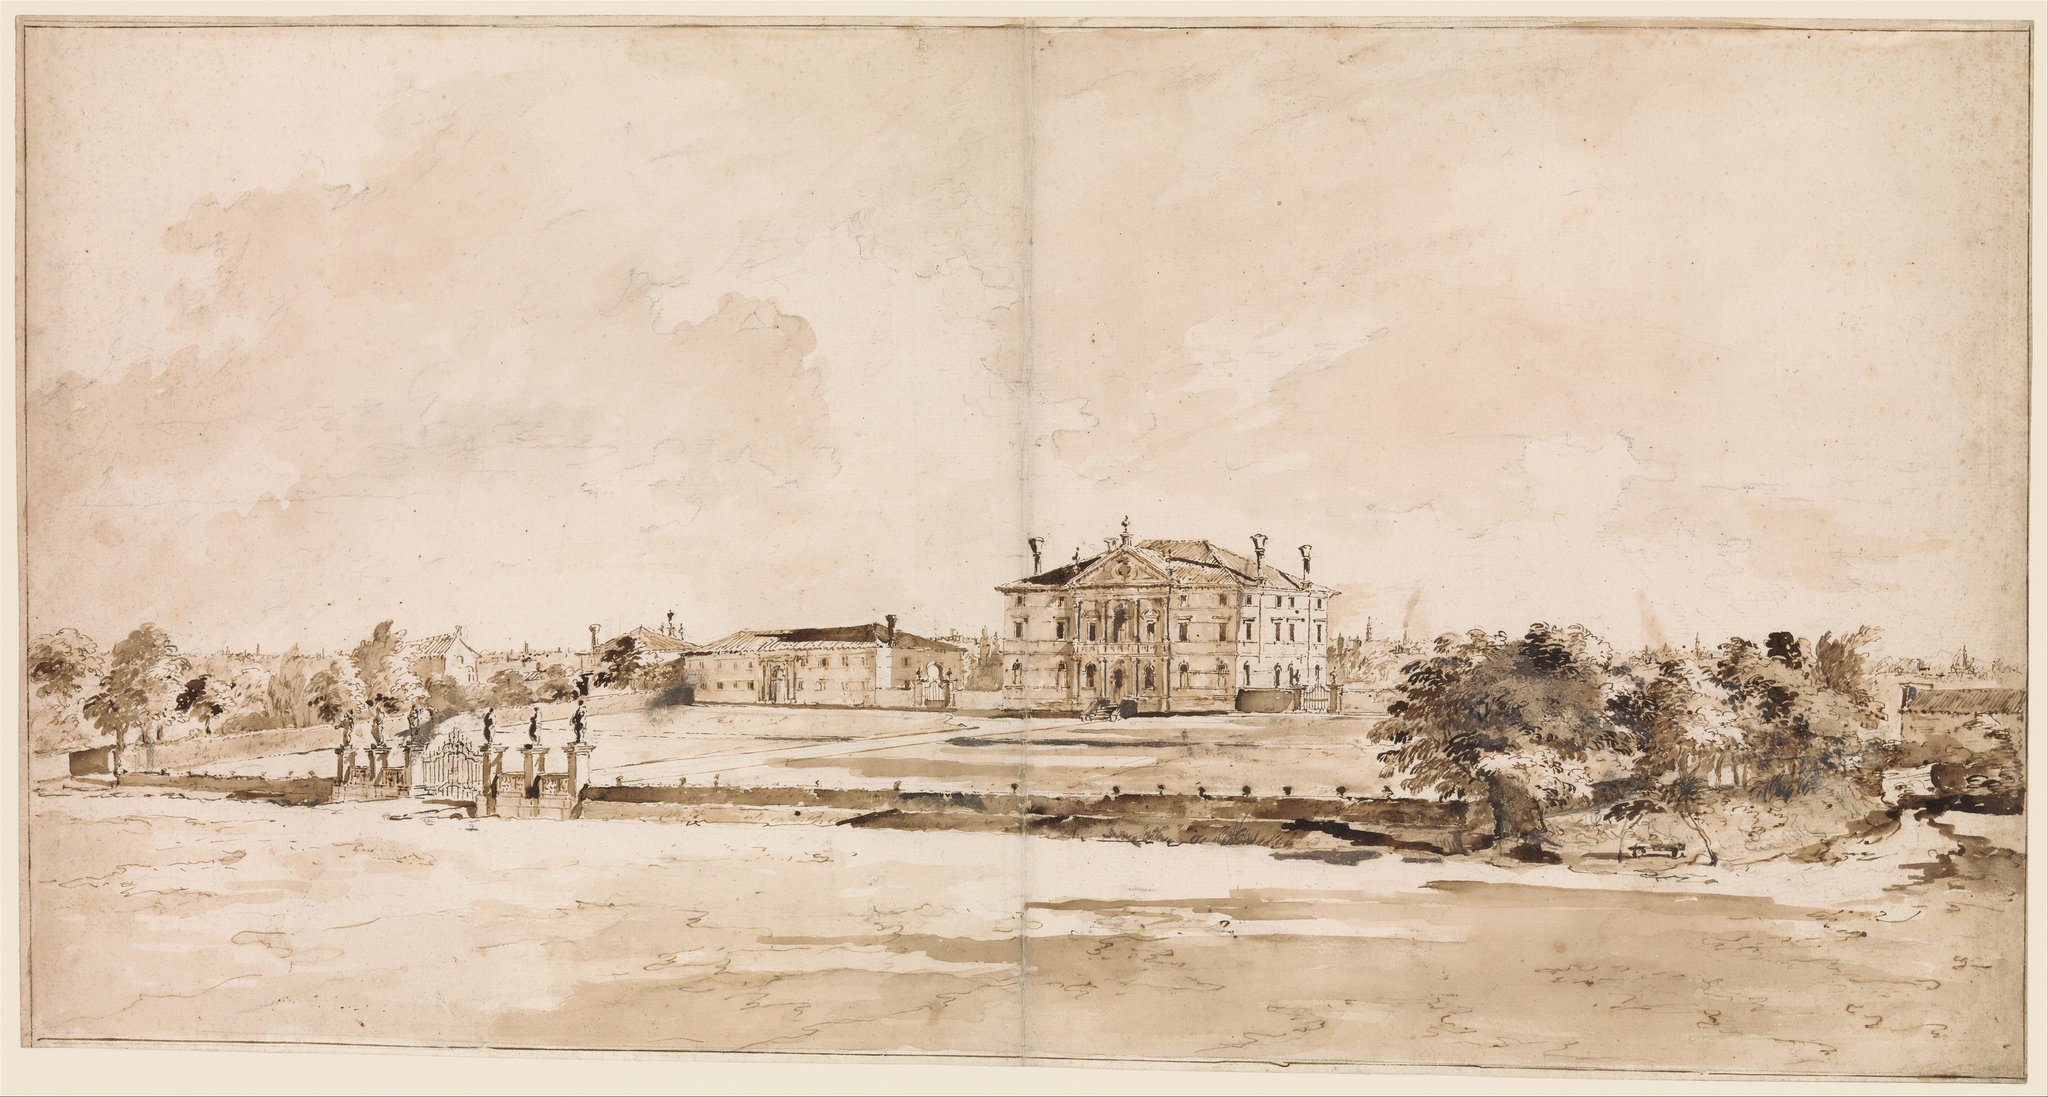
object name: drawing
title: The Villa Loredan, near Treviso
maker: francesco guardi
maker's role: artist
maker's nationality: italian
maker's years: 1712-1793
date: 1778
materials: chalk, gouache, ink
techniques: brush, pen, wash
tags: houses,trees